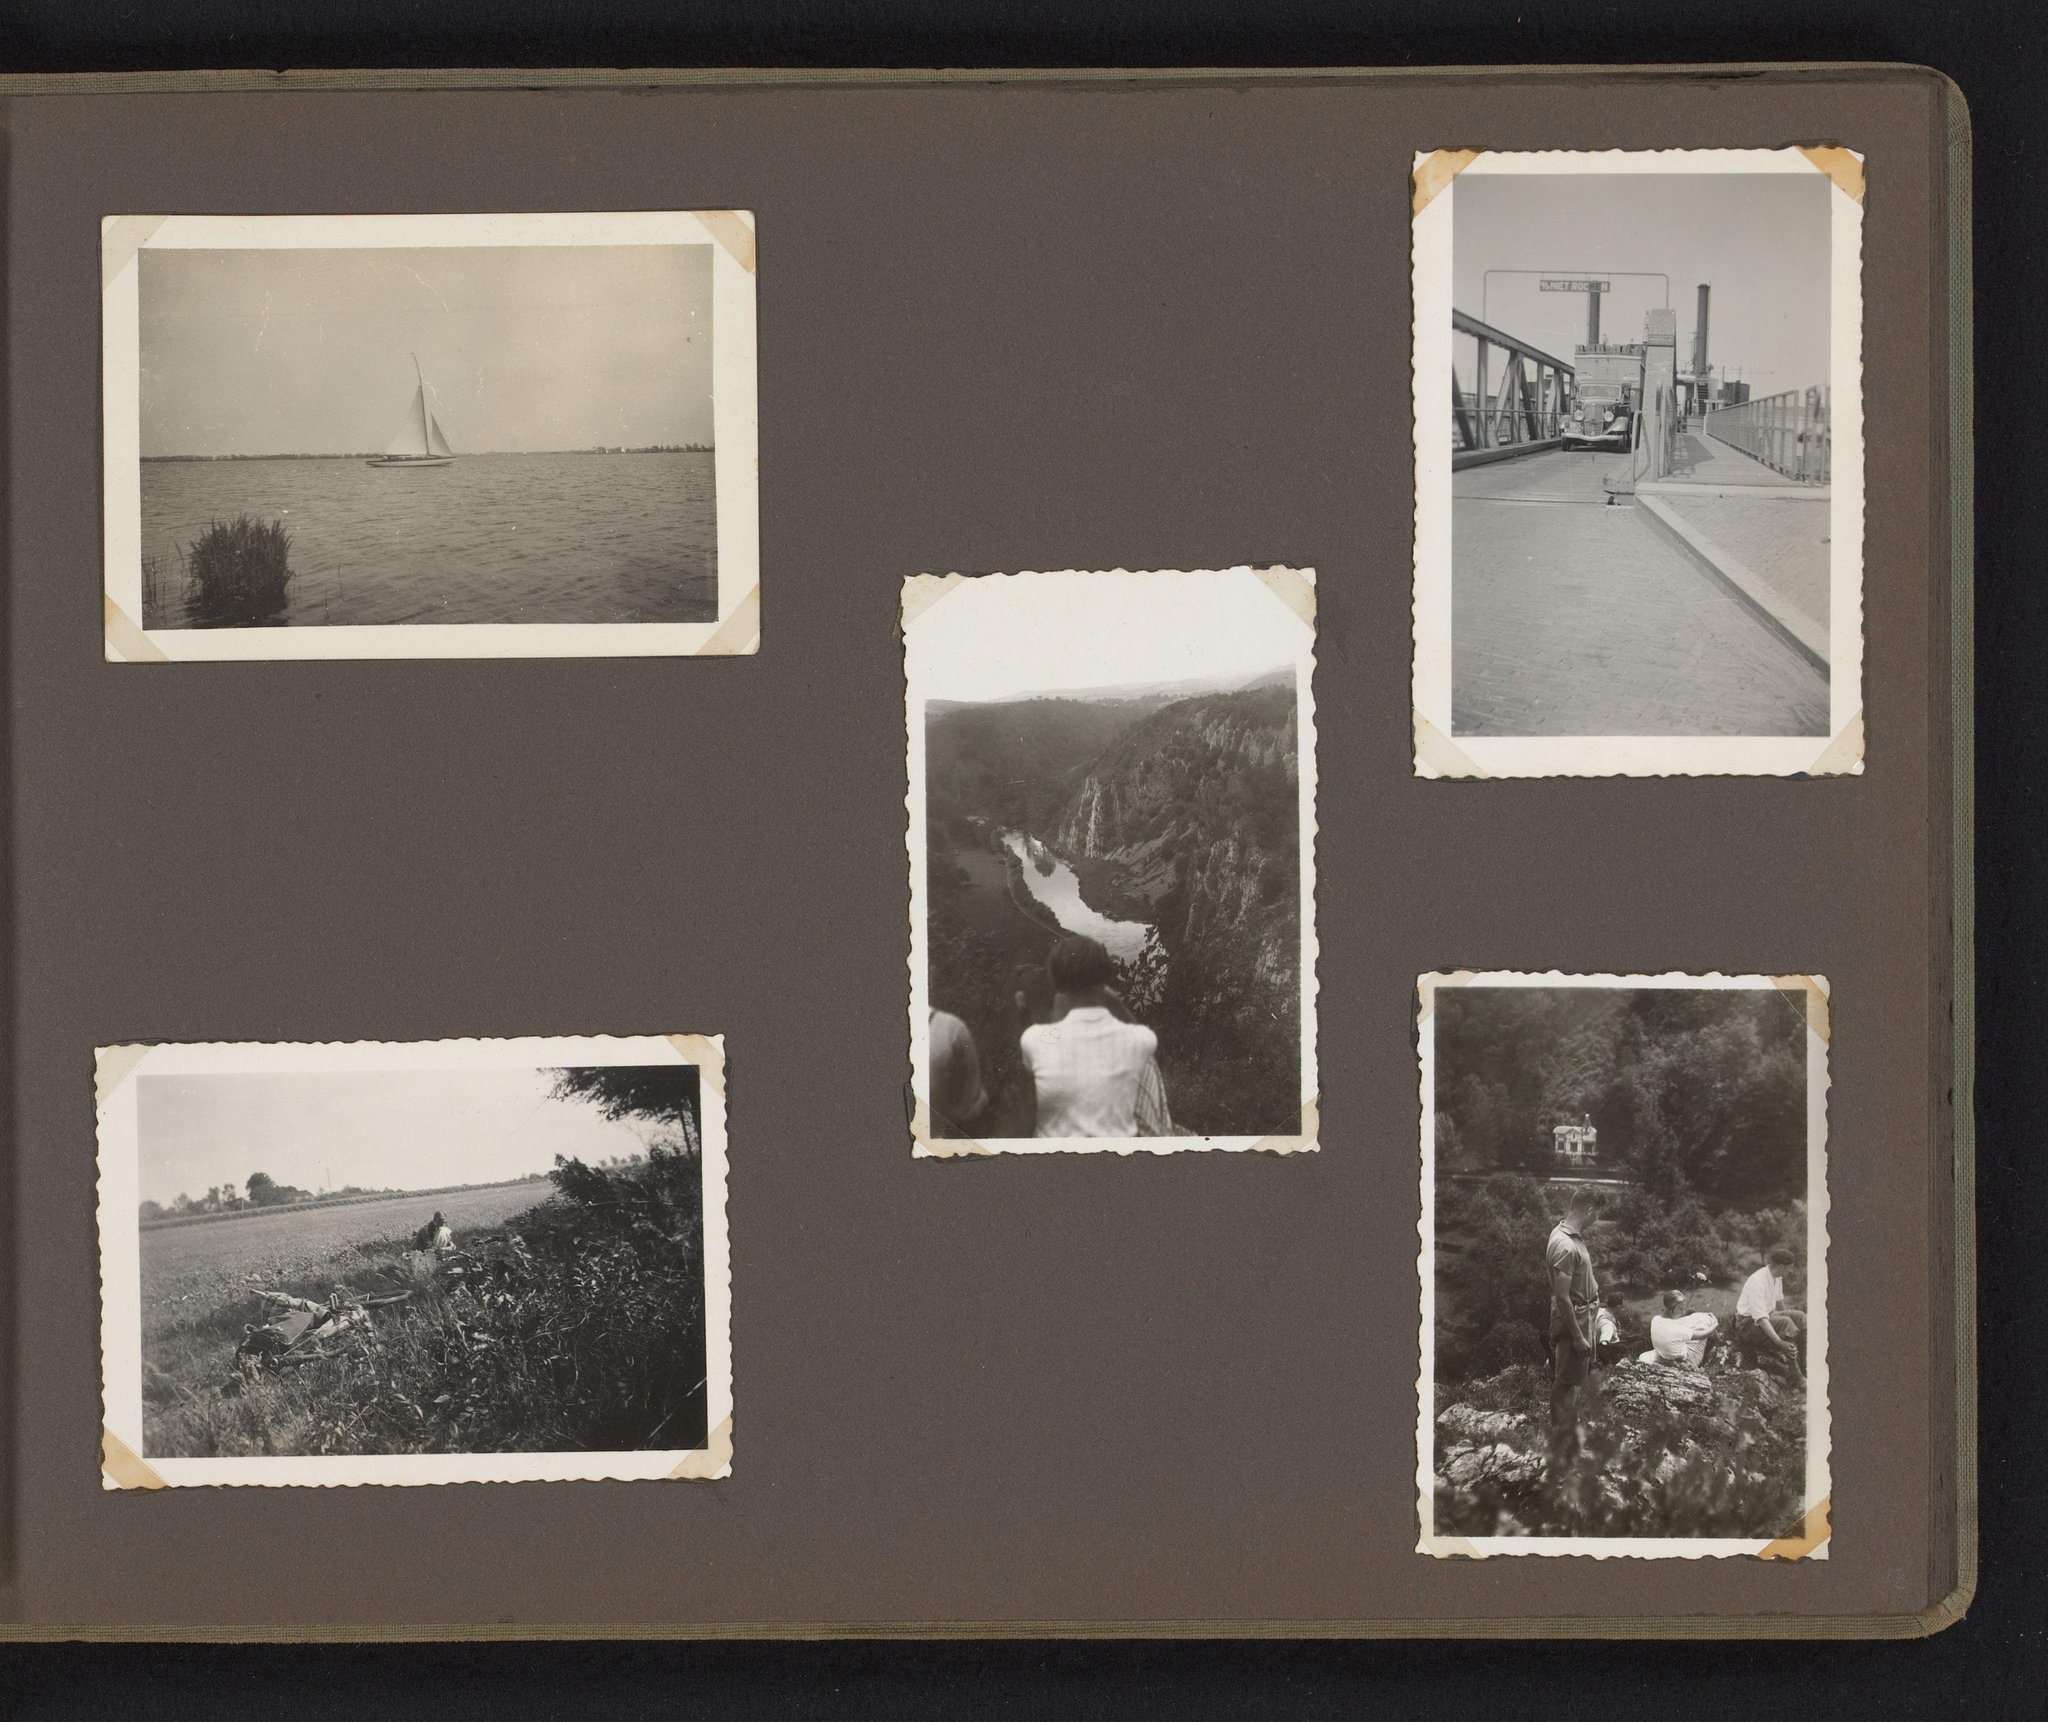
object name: album leaf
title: Vakantie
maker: Anonymous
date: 1935-1945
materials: cardboard, photographic support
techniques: gelatin silver print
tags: outing, pleasure trip, open-air recreation, netherlands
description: Albumblad met vijf foto's van een vakantie met een groep vrienden, deels Nederland, deels buitenland. Onderdeel van het fotoalbum van een jonge vrouw, ca. 1935-1945.